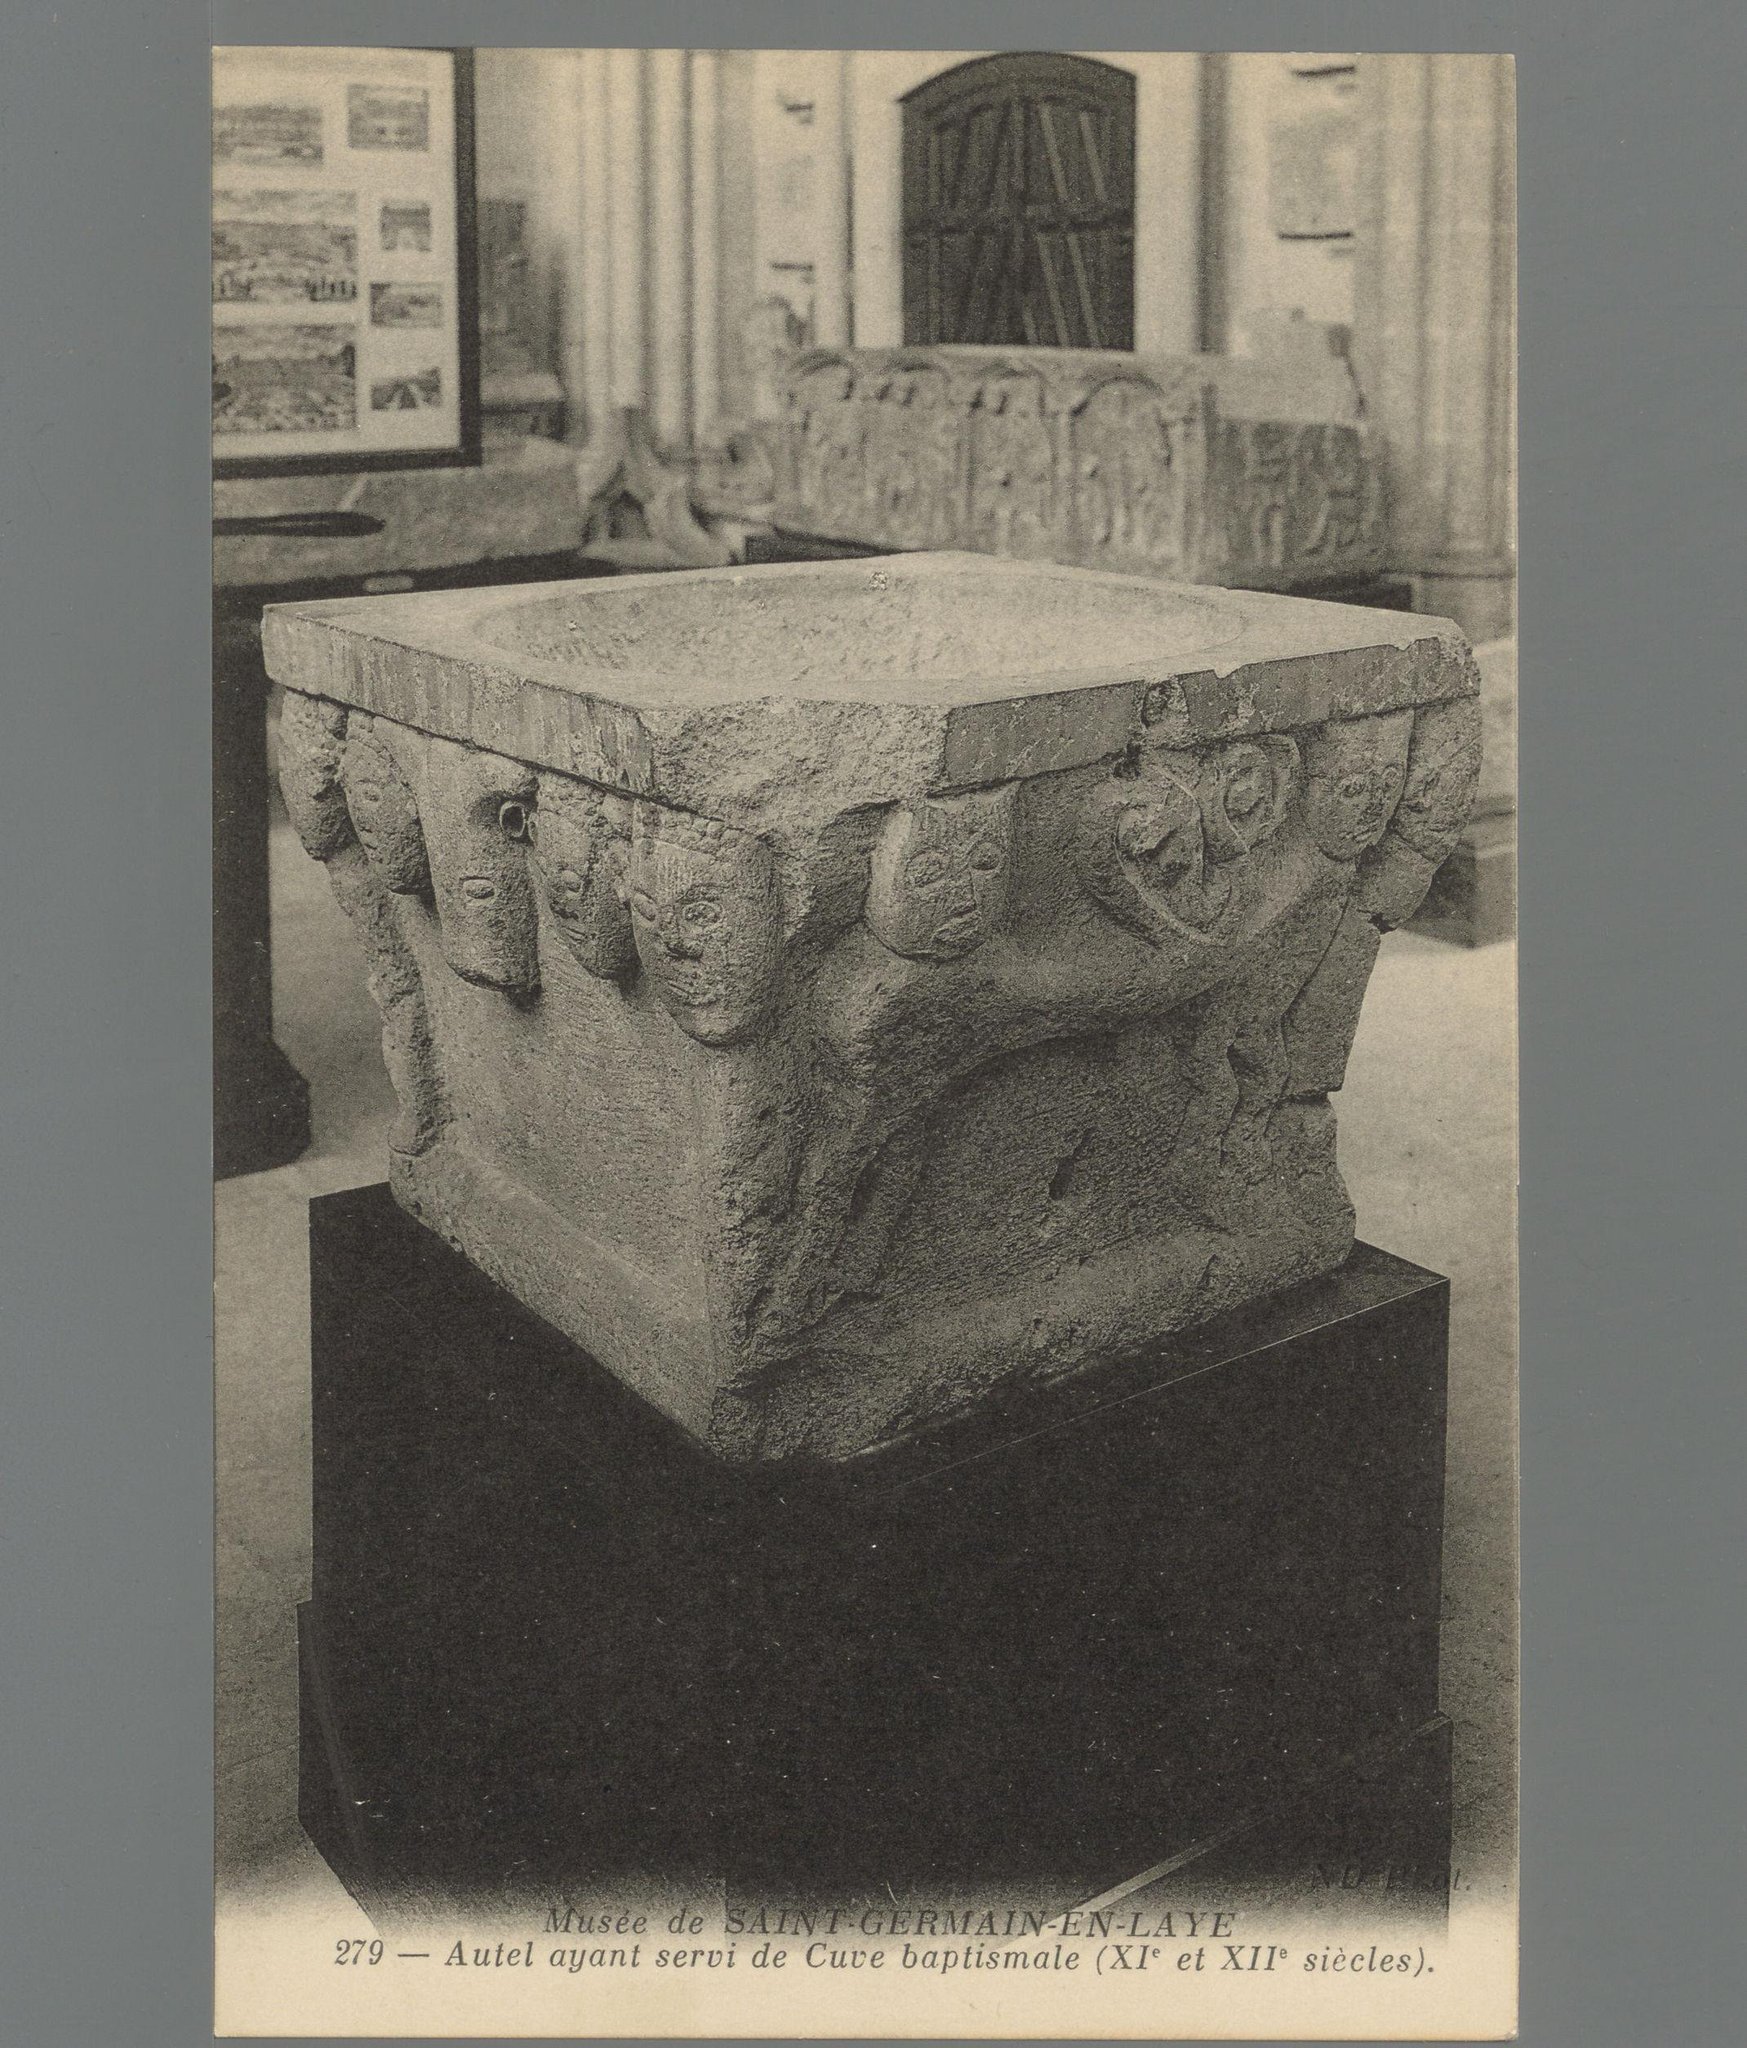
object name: photomechanical print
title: Musée de Saint-Germain-en-Laye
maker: Anonymous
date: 1903-1918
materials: cardboard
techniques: photograph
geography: paris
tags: baptismal font, permanent exhibition, museum